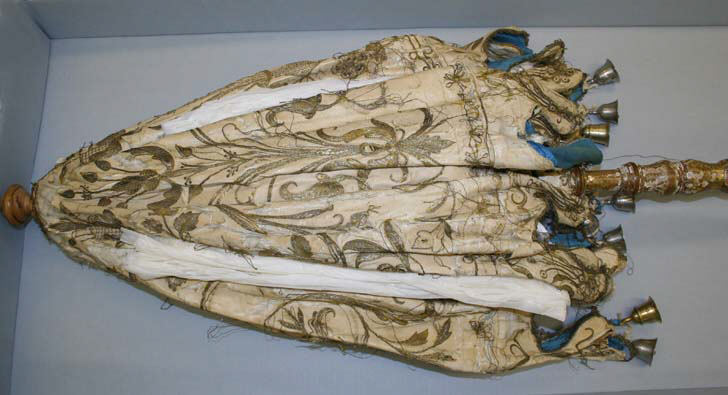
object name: umbrella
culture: italian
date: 1700-1725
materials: cotton, metal, silk, wood